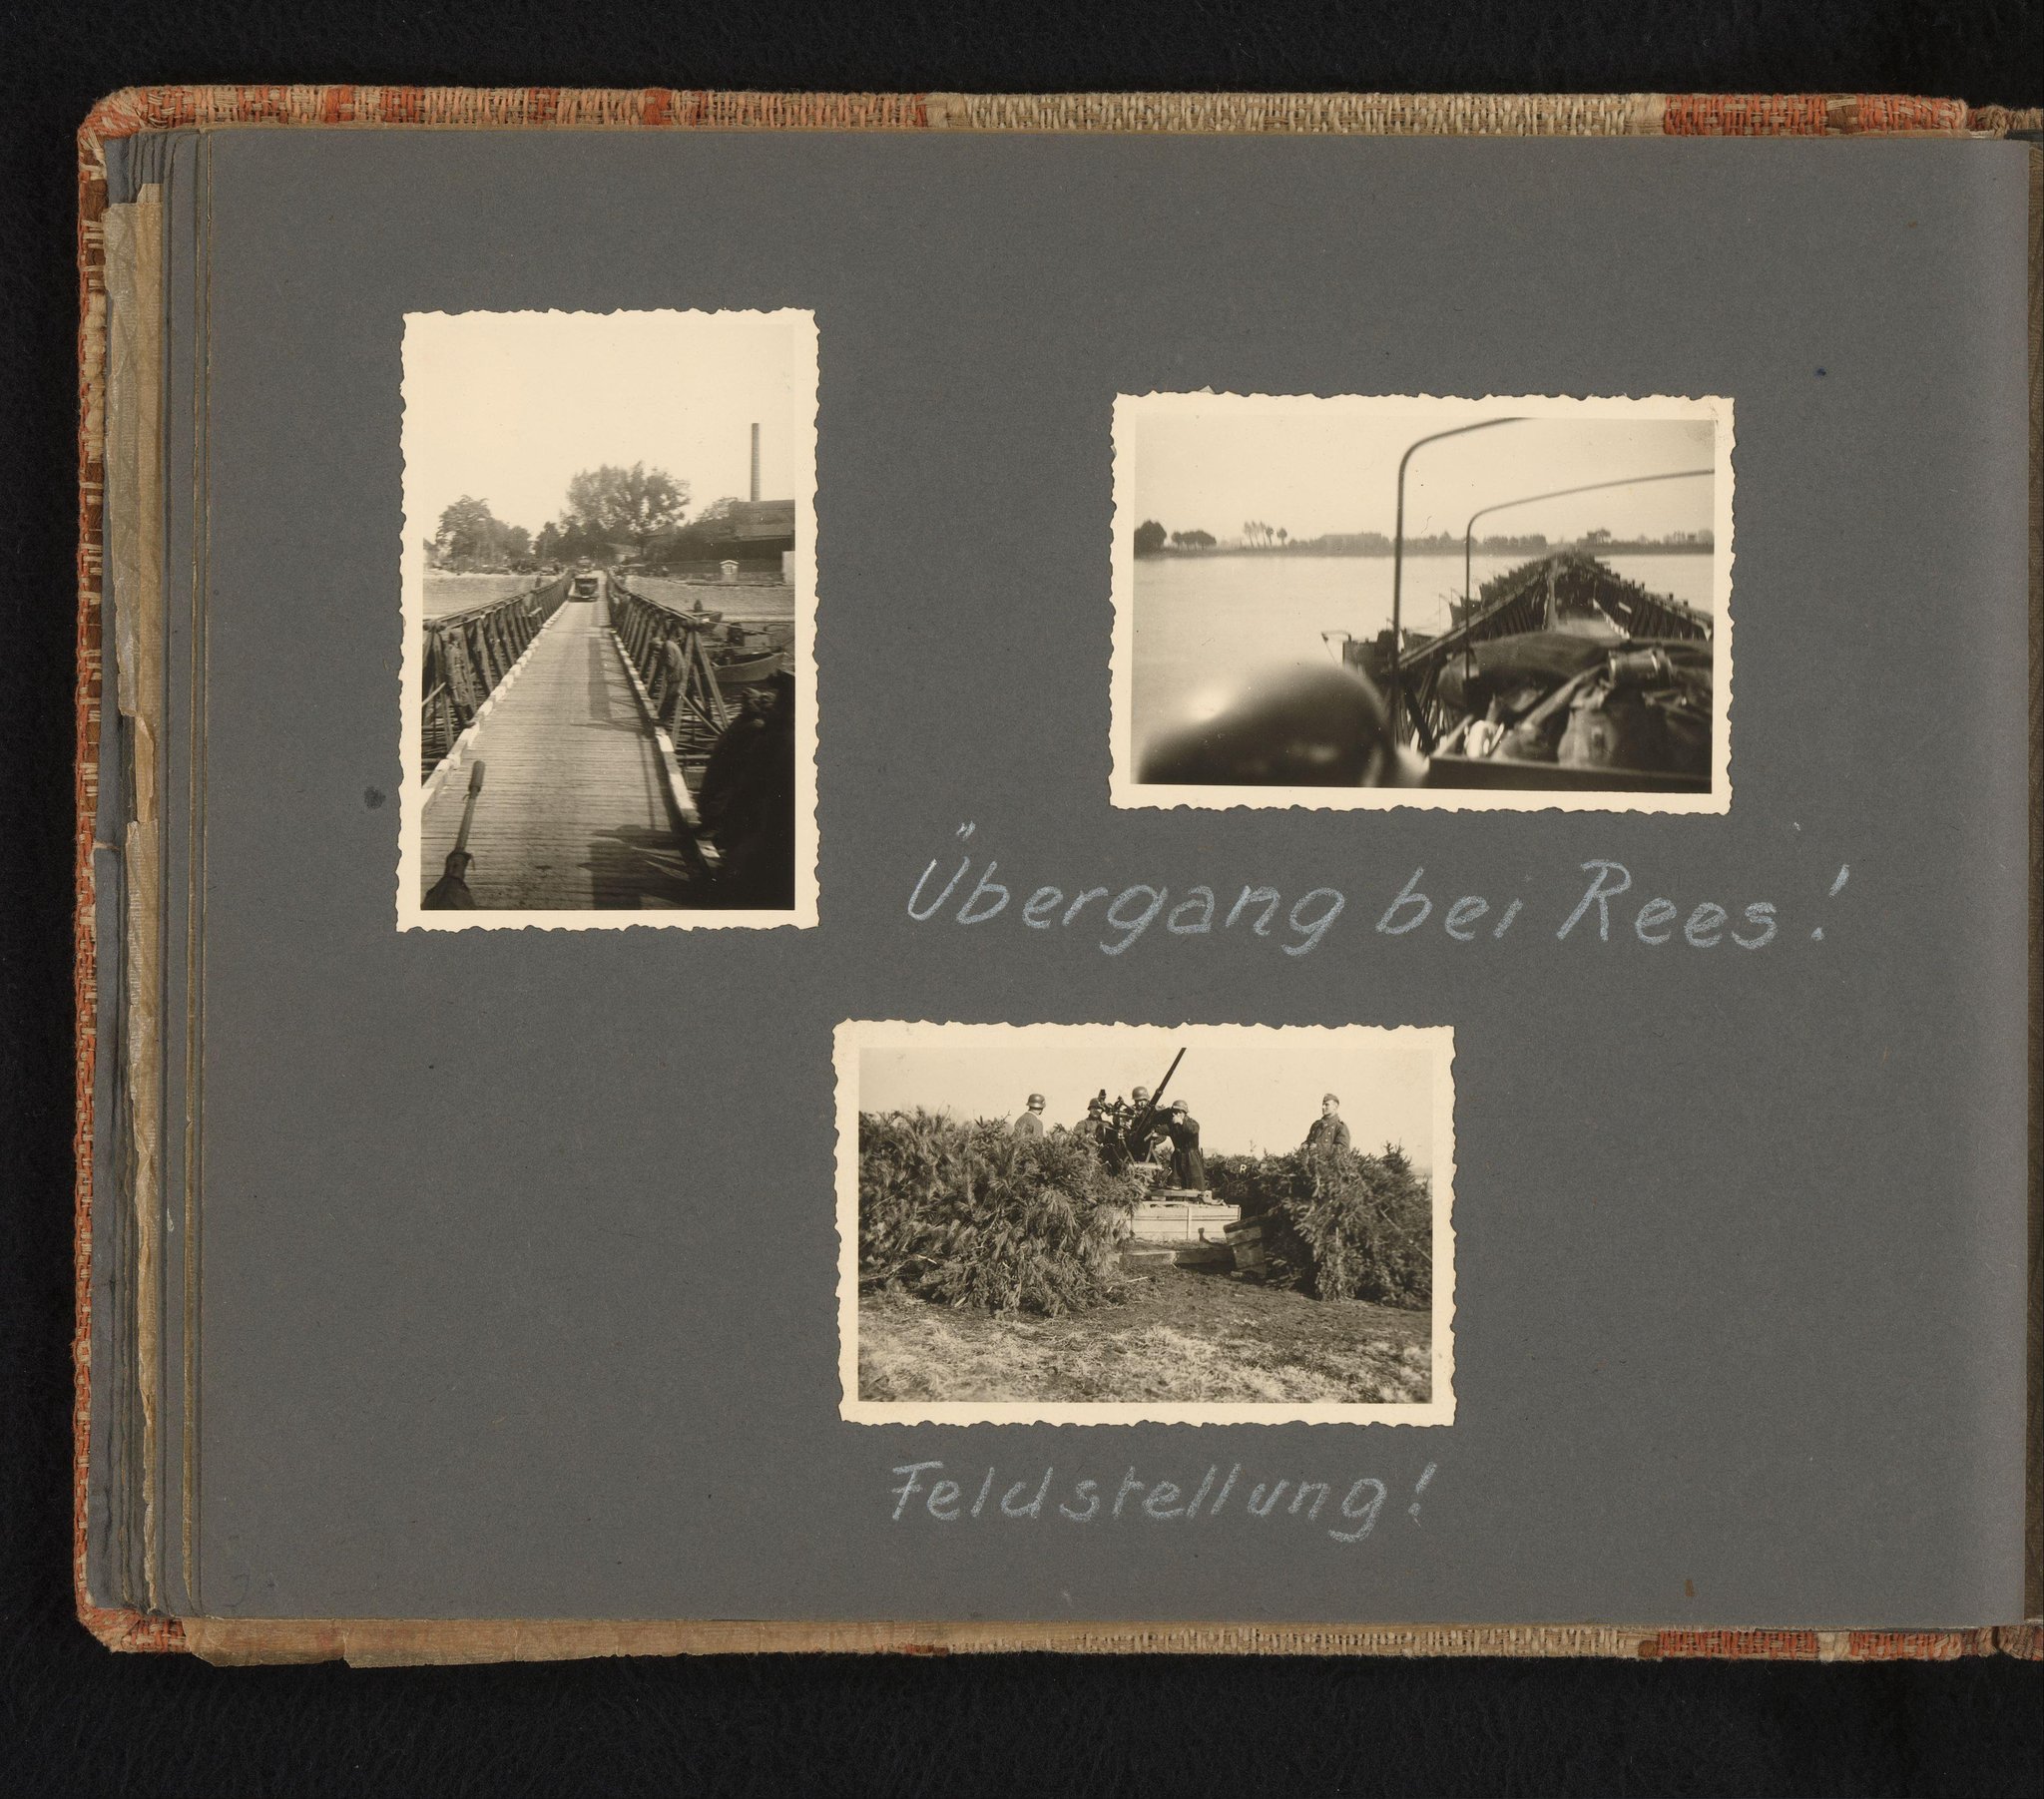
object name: photograph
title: Ubergang bei Rees! Feldstellung!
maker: Anonymous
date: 1940-1941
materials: paper, photographic support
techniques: gelatin silver print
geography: netherlands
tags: division of armed forces (+ artillery), firearms: cannon, pontoon bridge, netherlands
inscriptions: inscription: ‘Ubergang bei Rees! Feldstellung!’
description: Albumblad met twee foto's van een pontonbrug over de Rijn bij Rees en van een verdekte artilleriestelling. Onderdeel van het fotoalbum 'Kriegszeit in Holland' over de diensttijd in Nederland van Hans Heinemann van een Flak Regiment van de Luftverteidigungskommando van de Luftwaffe.